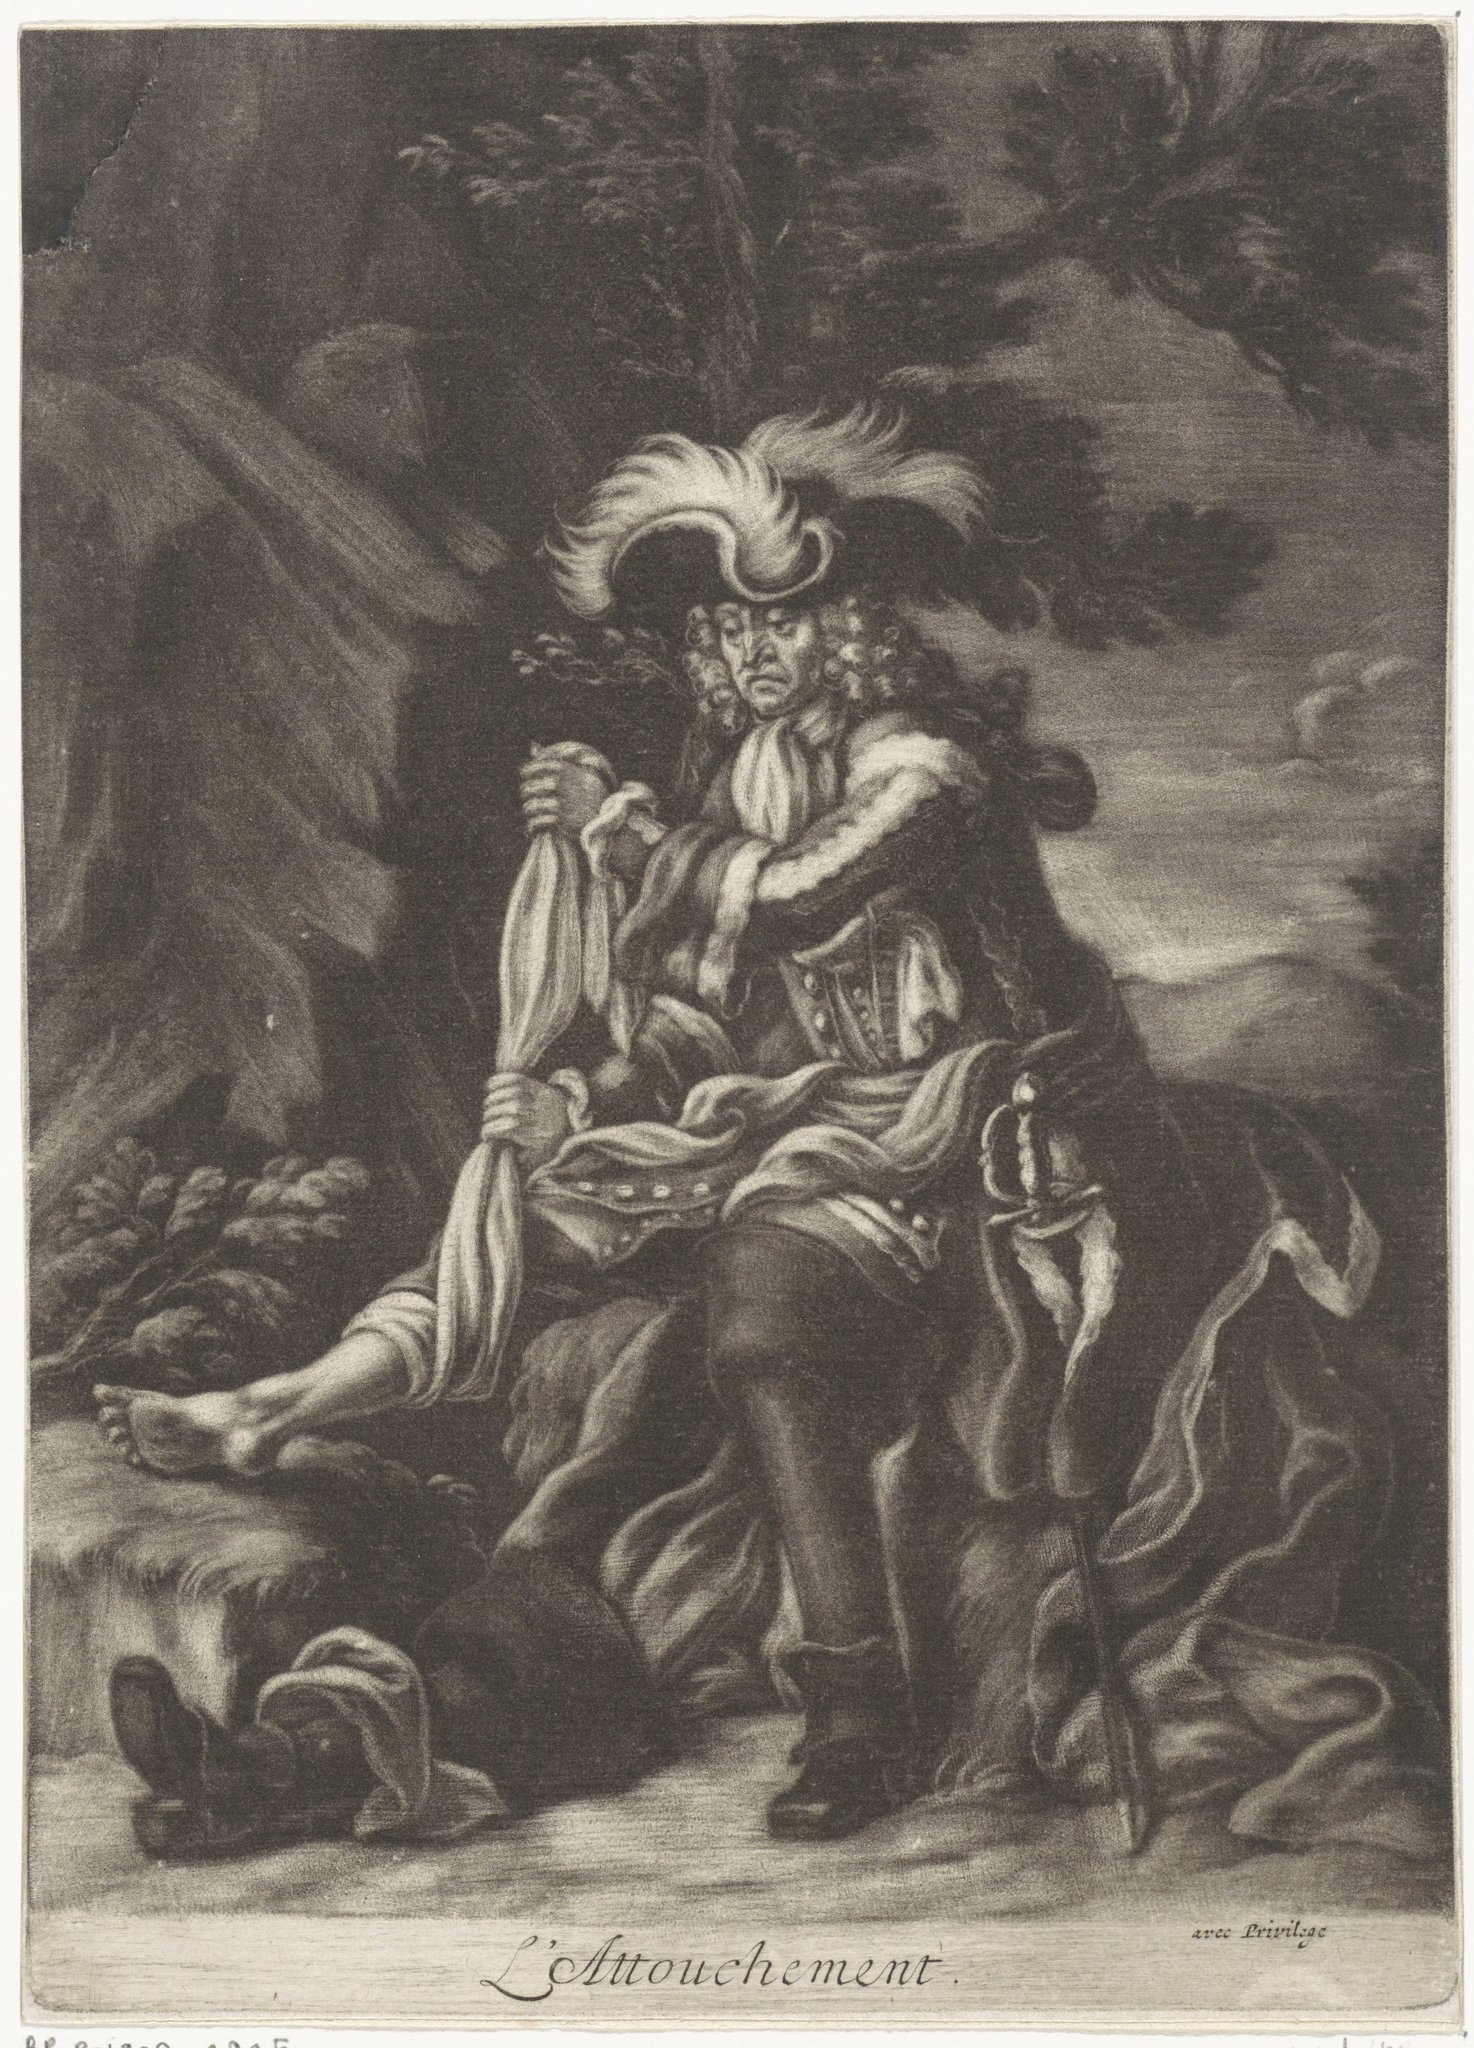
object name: print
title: Officier met een beenwond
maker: jacob gole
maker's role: print maker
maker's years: 1660-1724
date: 1670-1724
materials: paper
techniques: engraving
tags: infections and wounds, feeling (one of the five senses)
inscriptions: collector's mark: Lugt 2228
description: Een zittende officier verzorgt zijn beenwond.